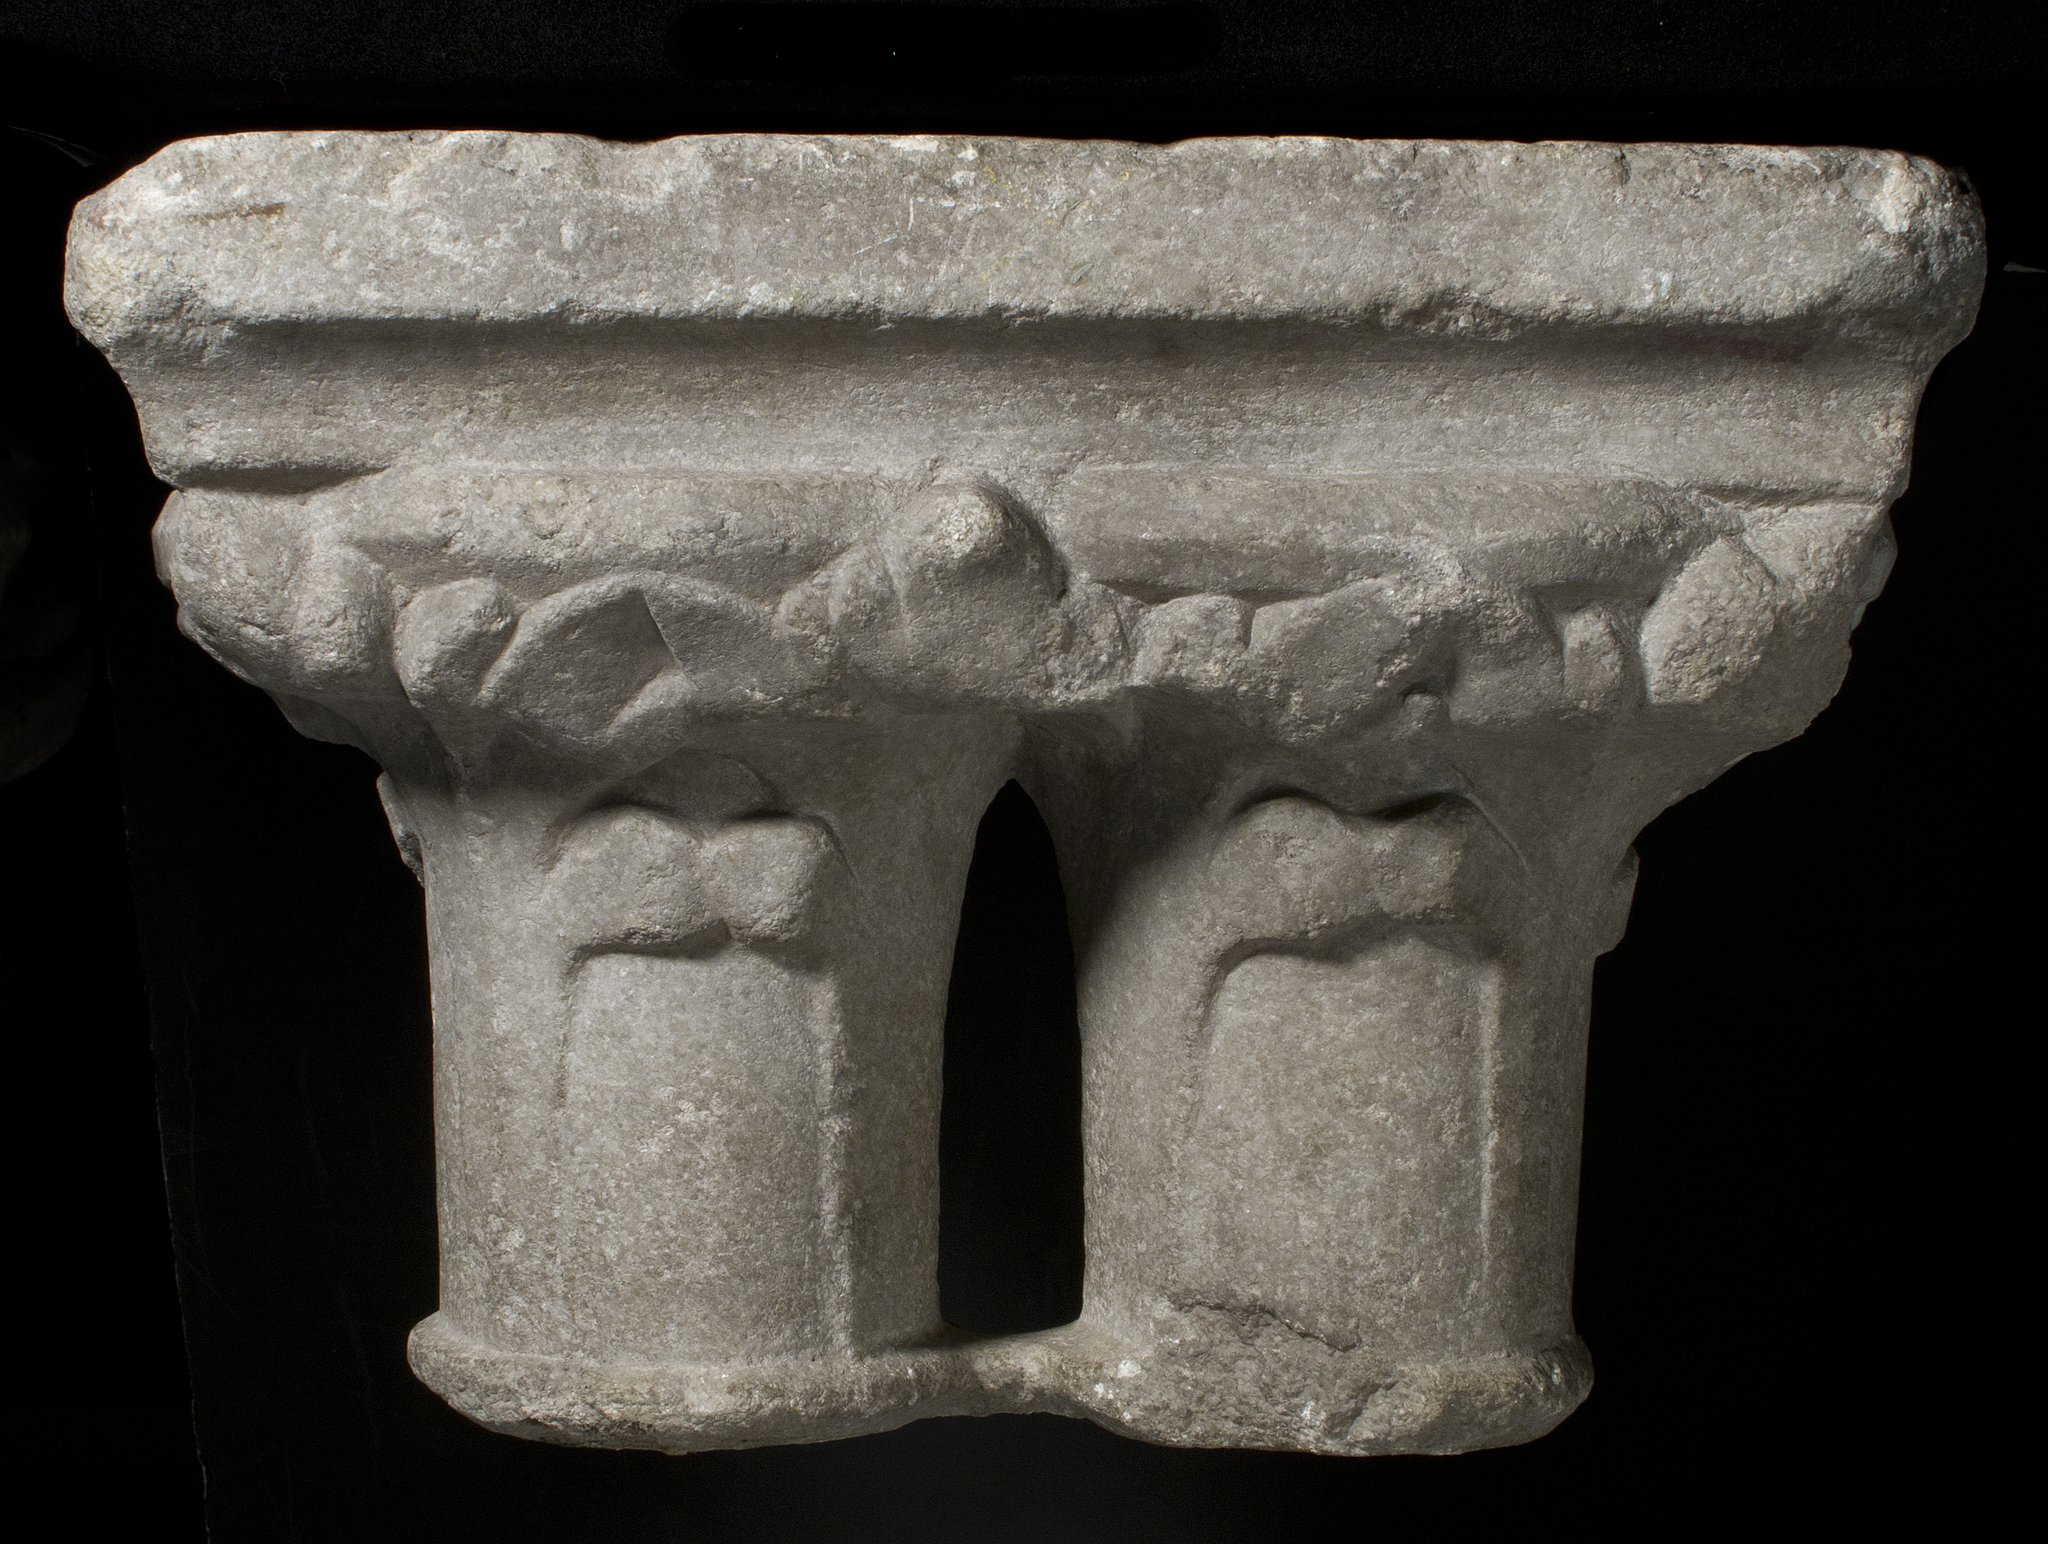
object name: capital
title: Double Capital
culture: french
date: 1267-1333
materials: marble